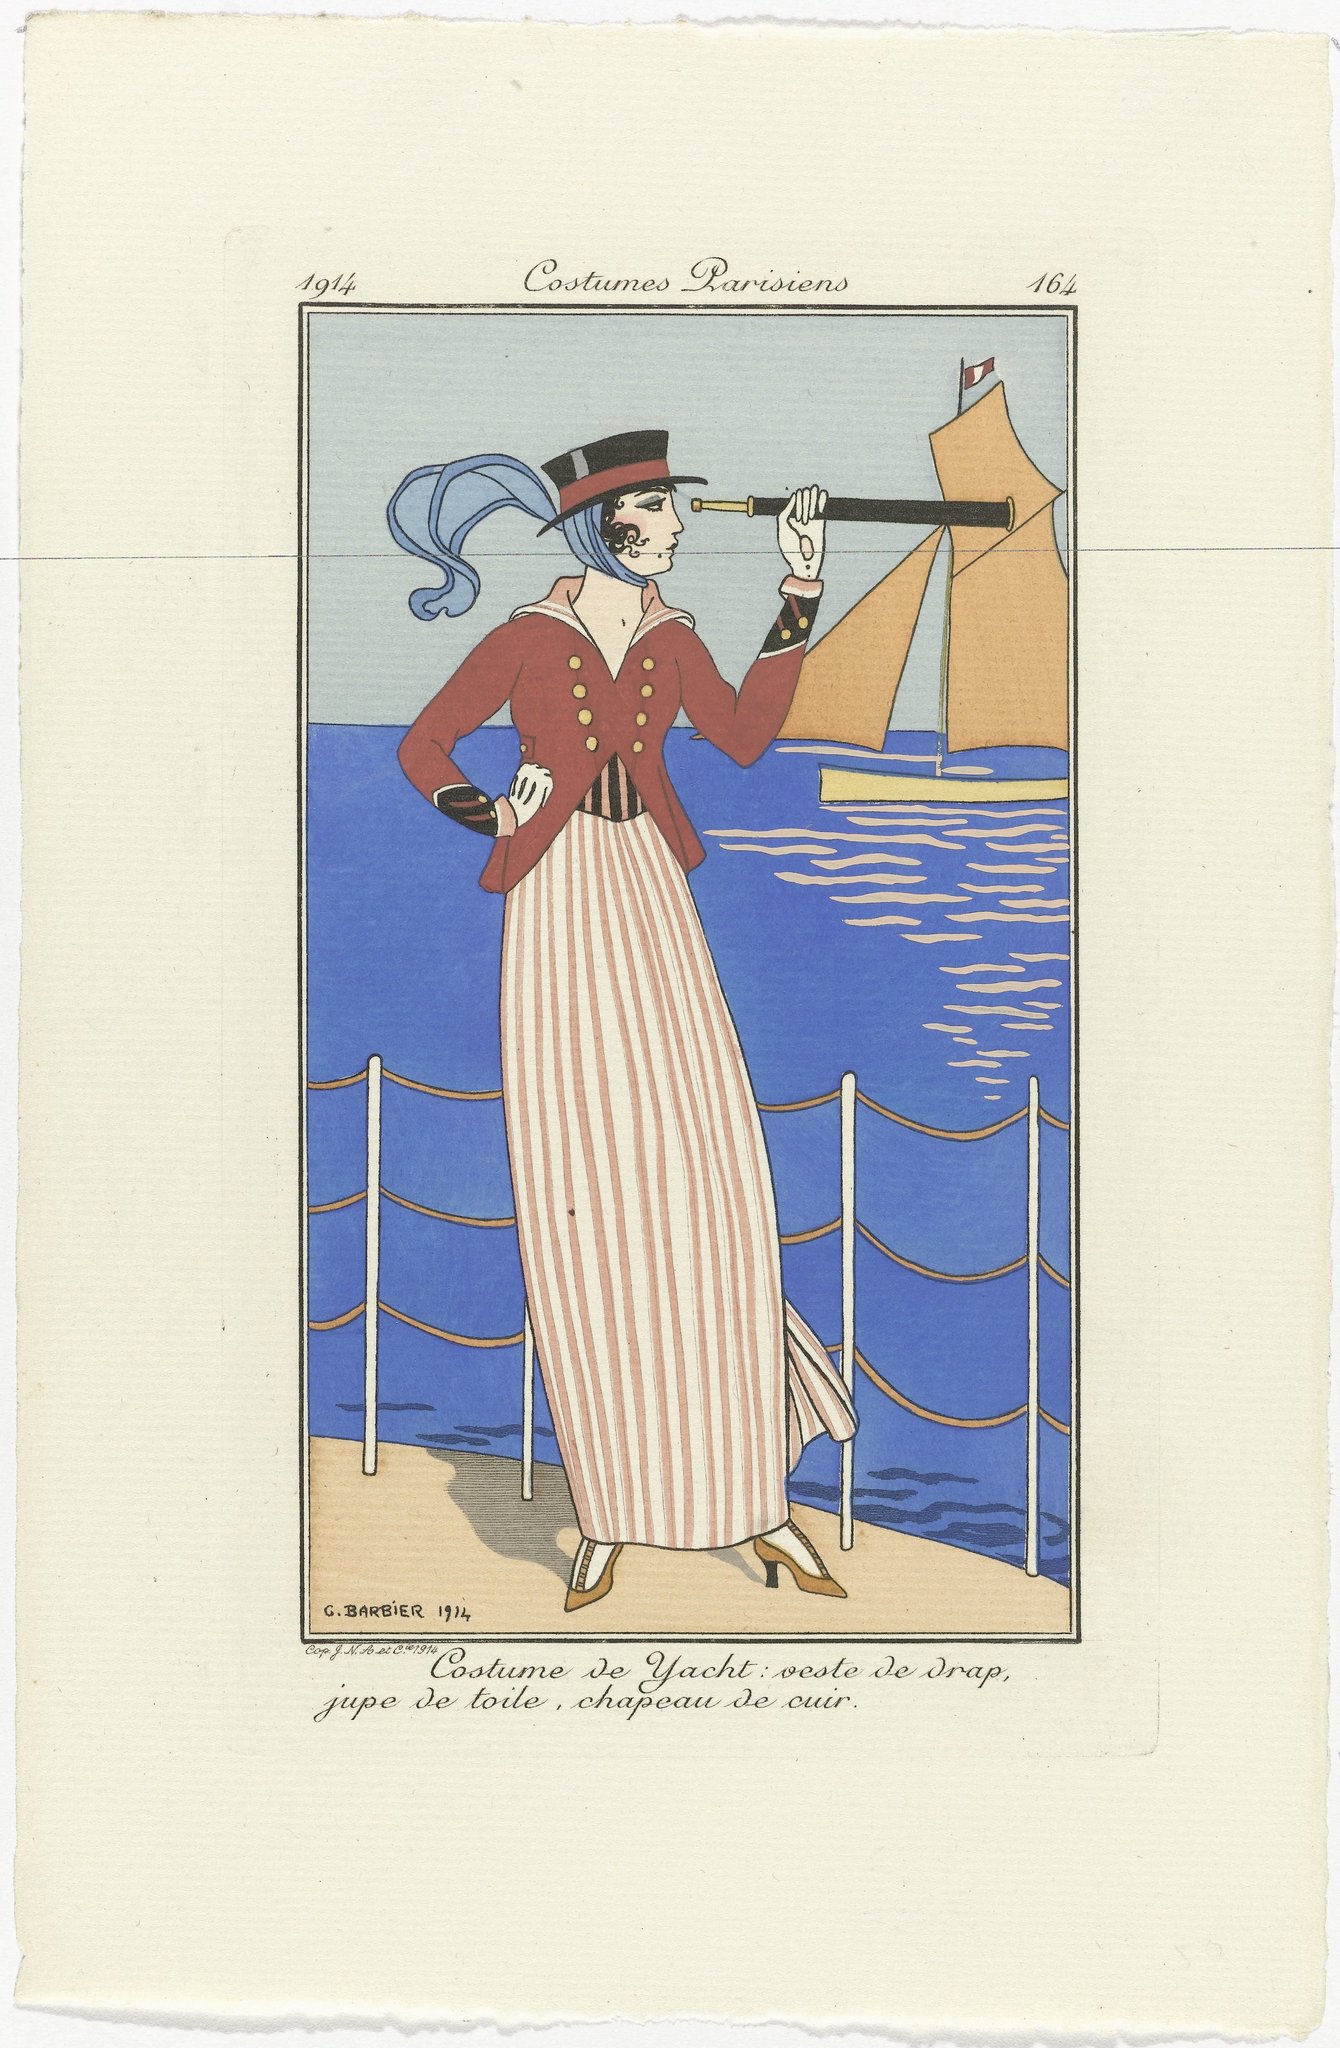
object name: fashion print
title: Journal des Dames et des Modes, Costumes Parisiens, 1914, No. 164 : Costume de Yacht (...)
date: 1914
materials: paper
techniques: engraving, hand coloring, pochoir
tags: head-gear: hat (+ leather used for clothes), sailing (sport) (+ equipment, outfit (sports, games, etc.)), coat (+ women's clothes), fashion plates, head-gear: hat (+ women's clothes), skirt (+ women's clothes), binoculars, spy-glass, etc.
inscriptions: title: ‘Costumes Parisiens’, caption: ‘Costume de Yacht : veste de drap, jupe de toile, chapeau de cuir.’, inscription: ‘Cop. J. N. A. et Cie 1914’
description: Vrouw in kostuum voor een pleziervaart: jasje van laken op een rok van gestreept doek. Hoed van leer. Verrekijker in de hand. Op de achtergrond een zeilschip. Prent uit het modetijdschrift Journal des Dames et des Modes (1912-1914).